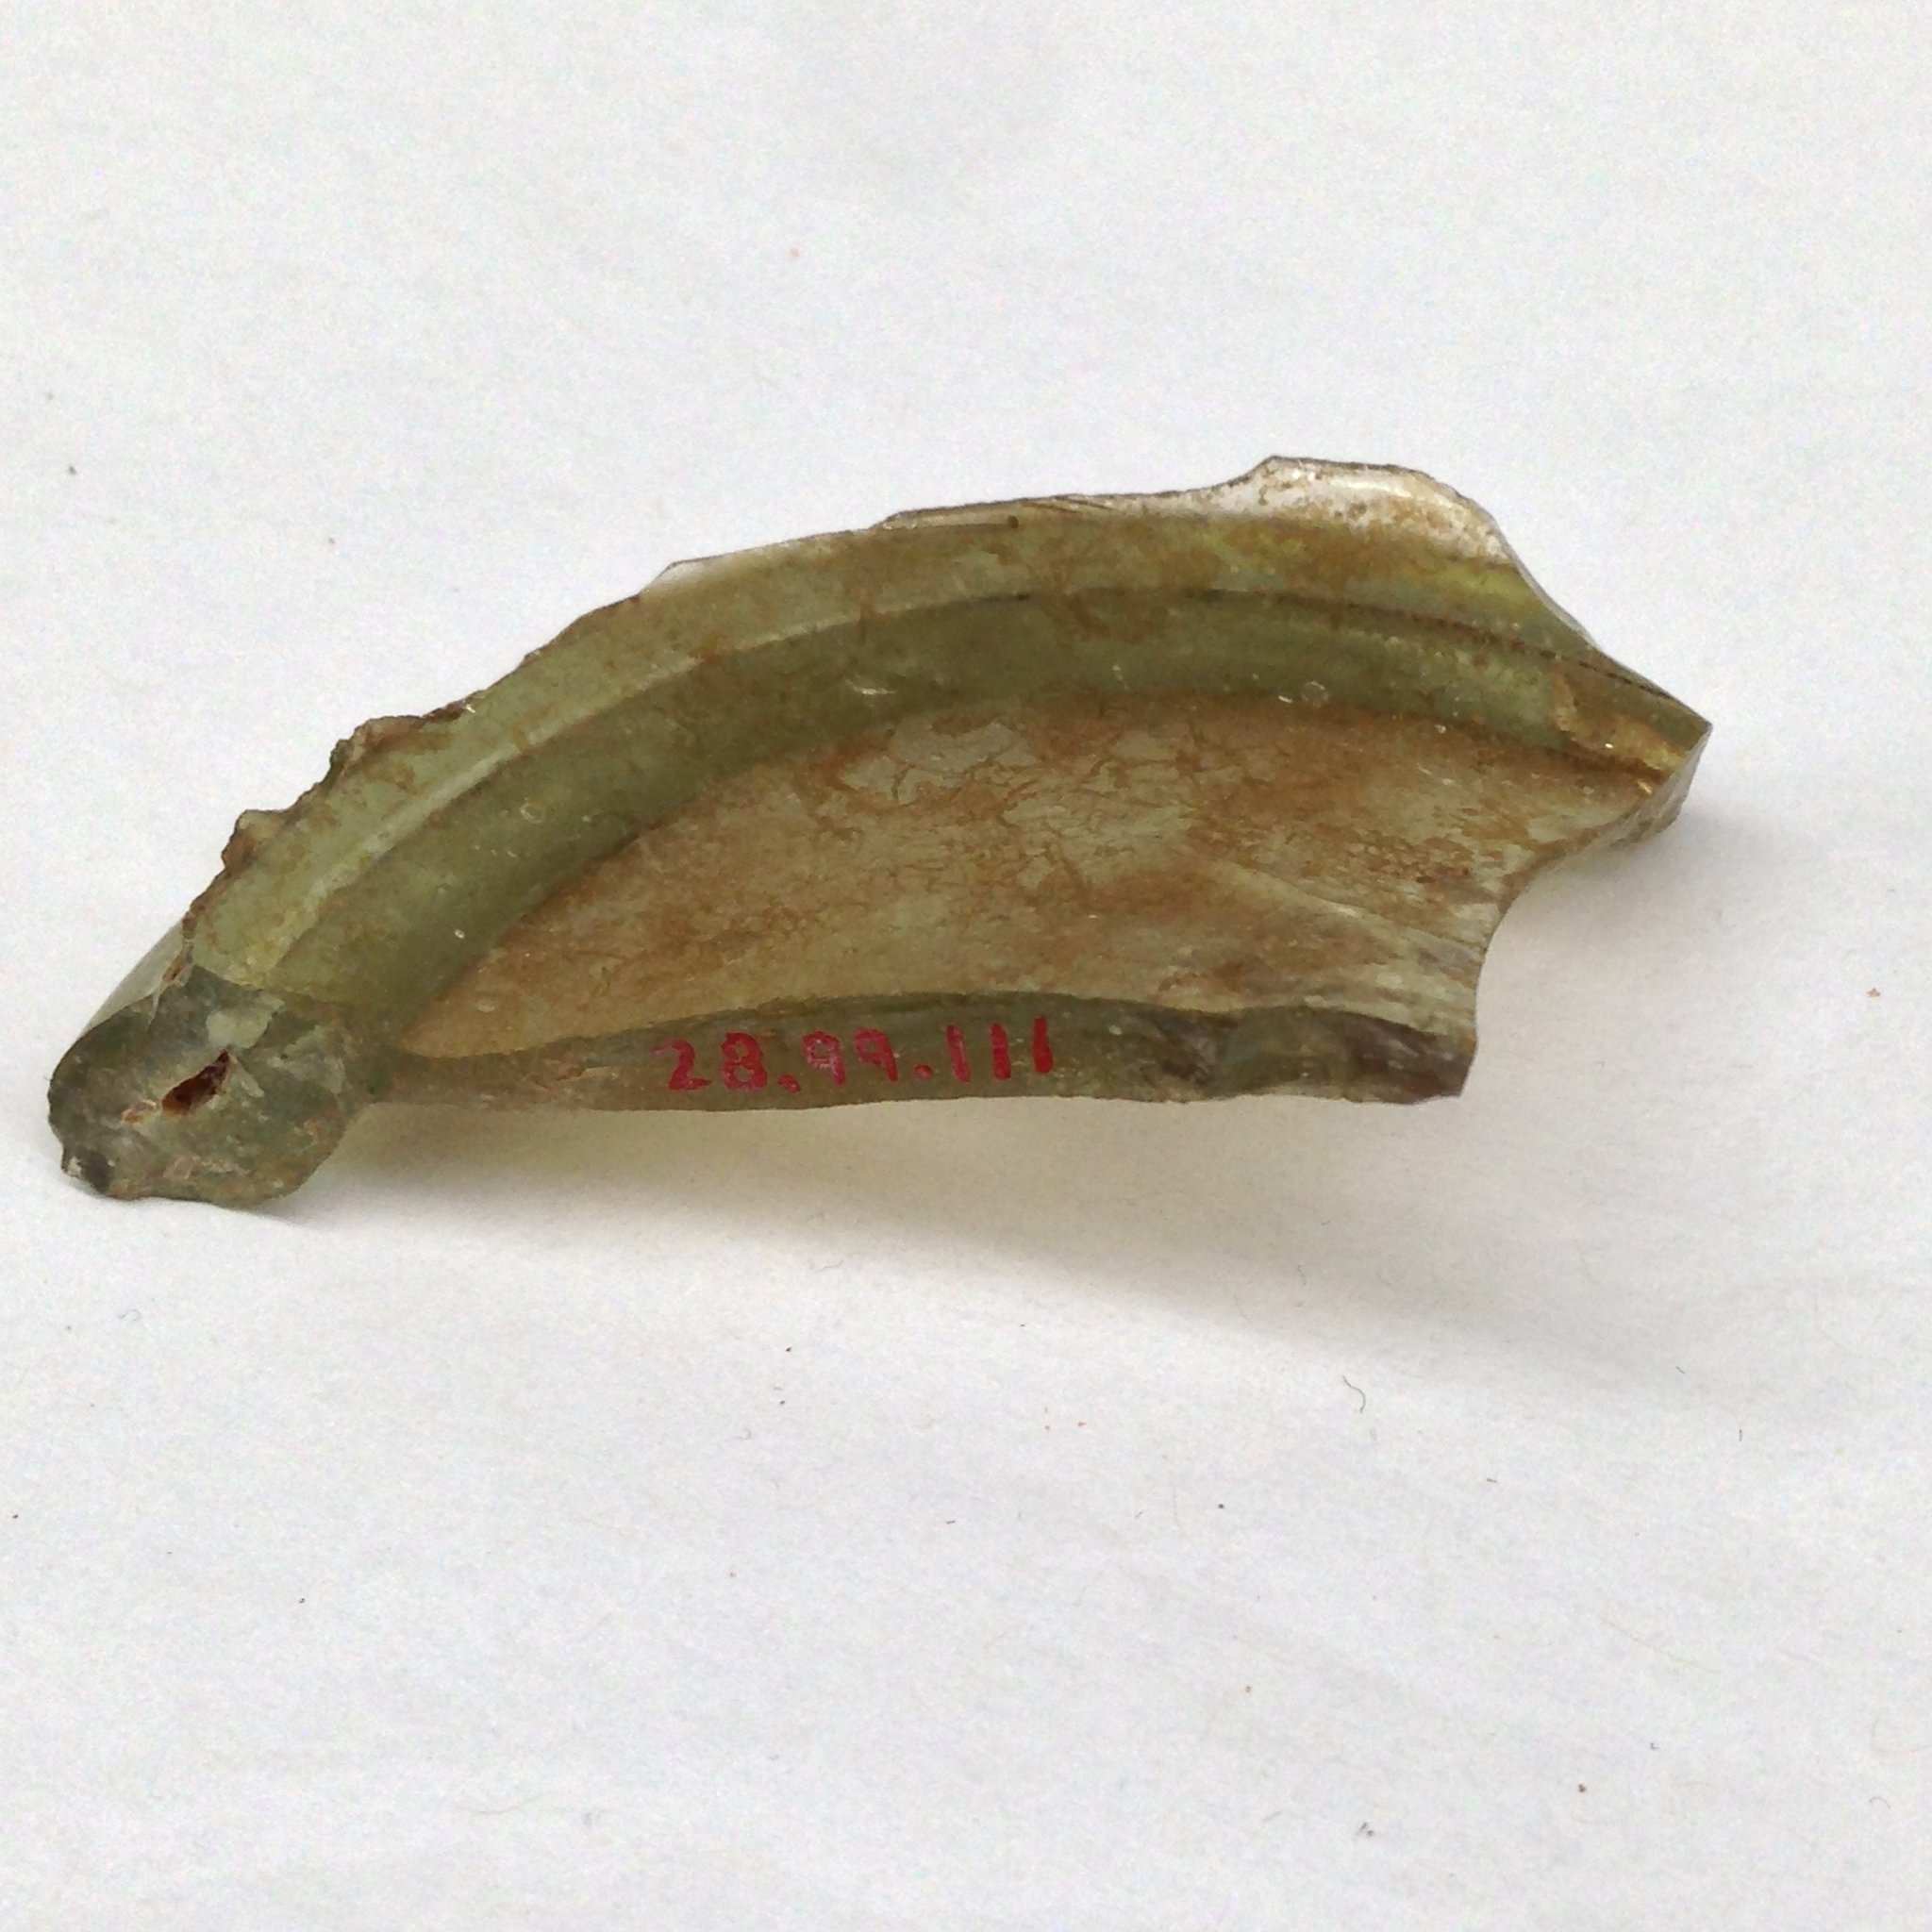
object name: fragment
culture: european or middle eastern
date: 1150-1250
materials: ceramic, glass